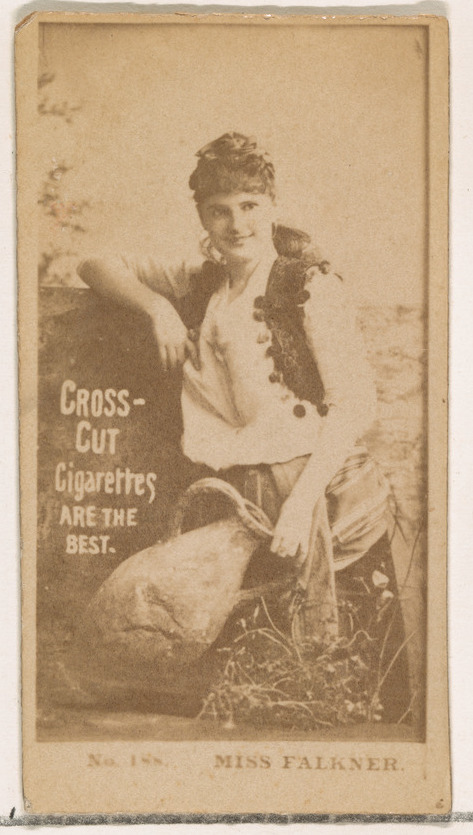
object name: print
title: Card Number 188, Miss Falkner, from the Actors and Actresses series (N145-2) issued by Duke Sons & Co. to promote Cross Cut Cigarettes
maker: w. duke, sons & co.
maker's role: publisher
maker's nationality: american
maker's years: 1870-1920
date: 1880-1889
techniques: albumen silver print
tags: portraits,women,actresses